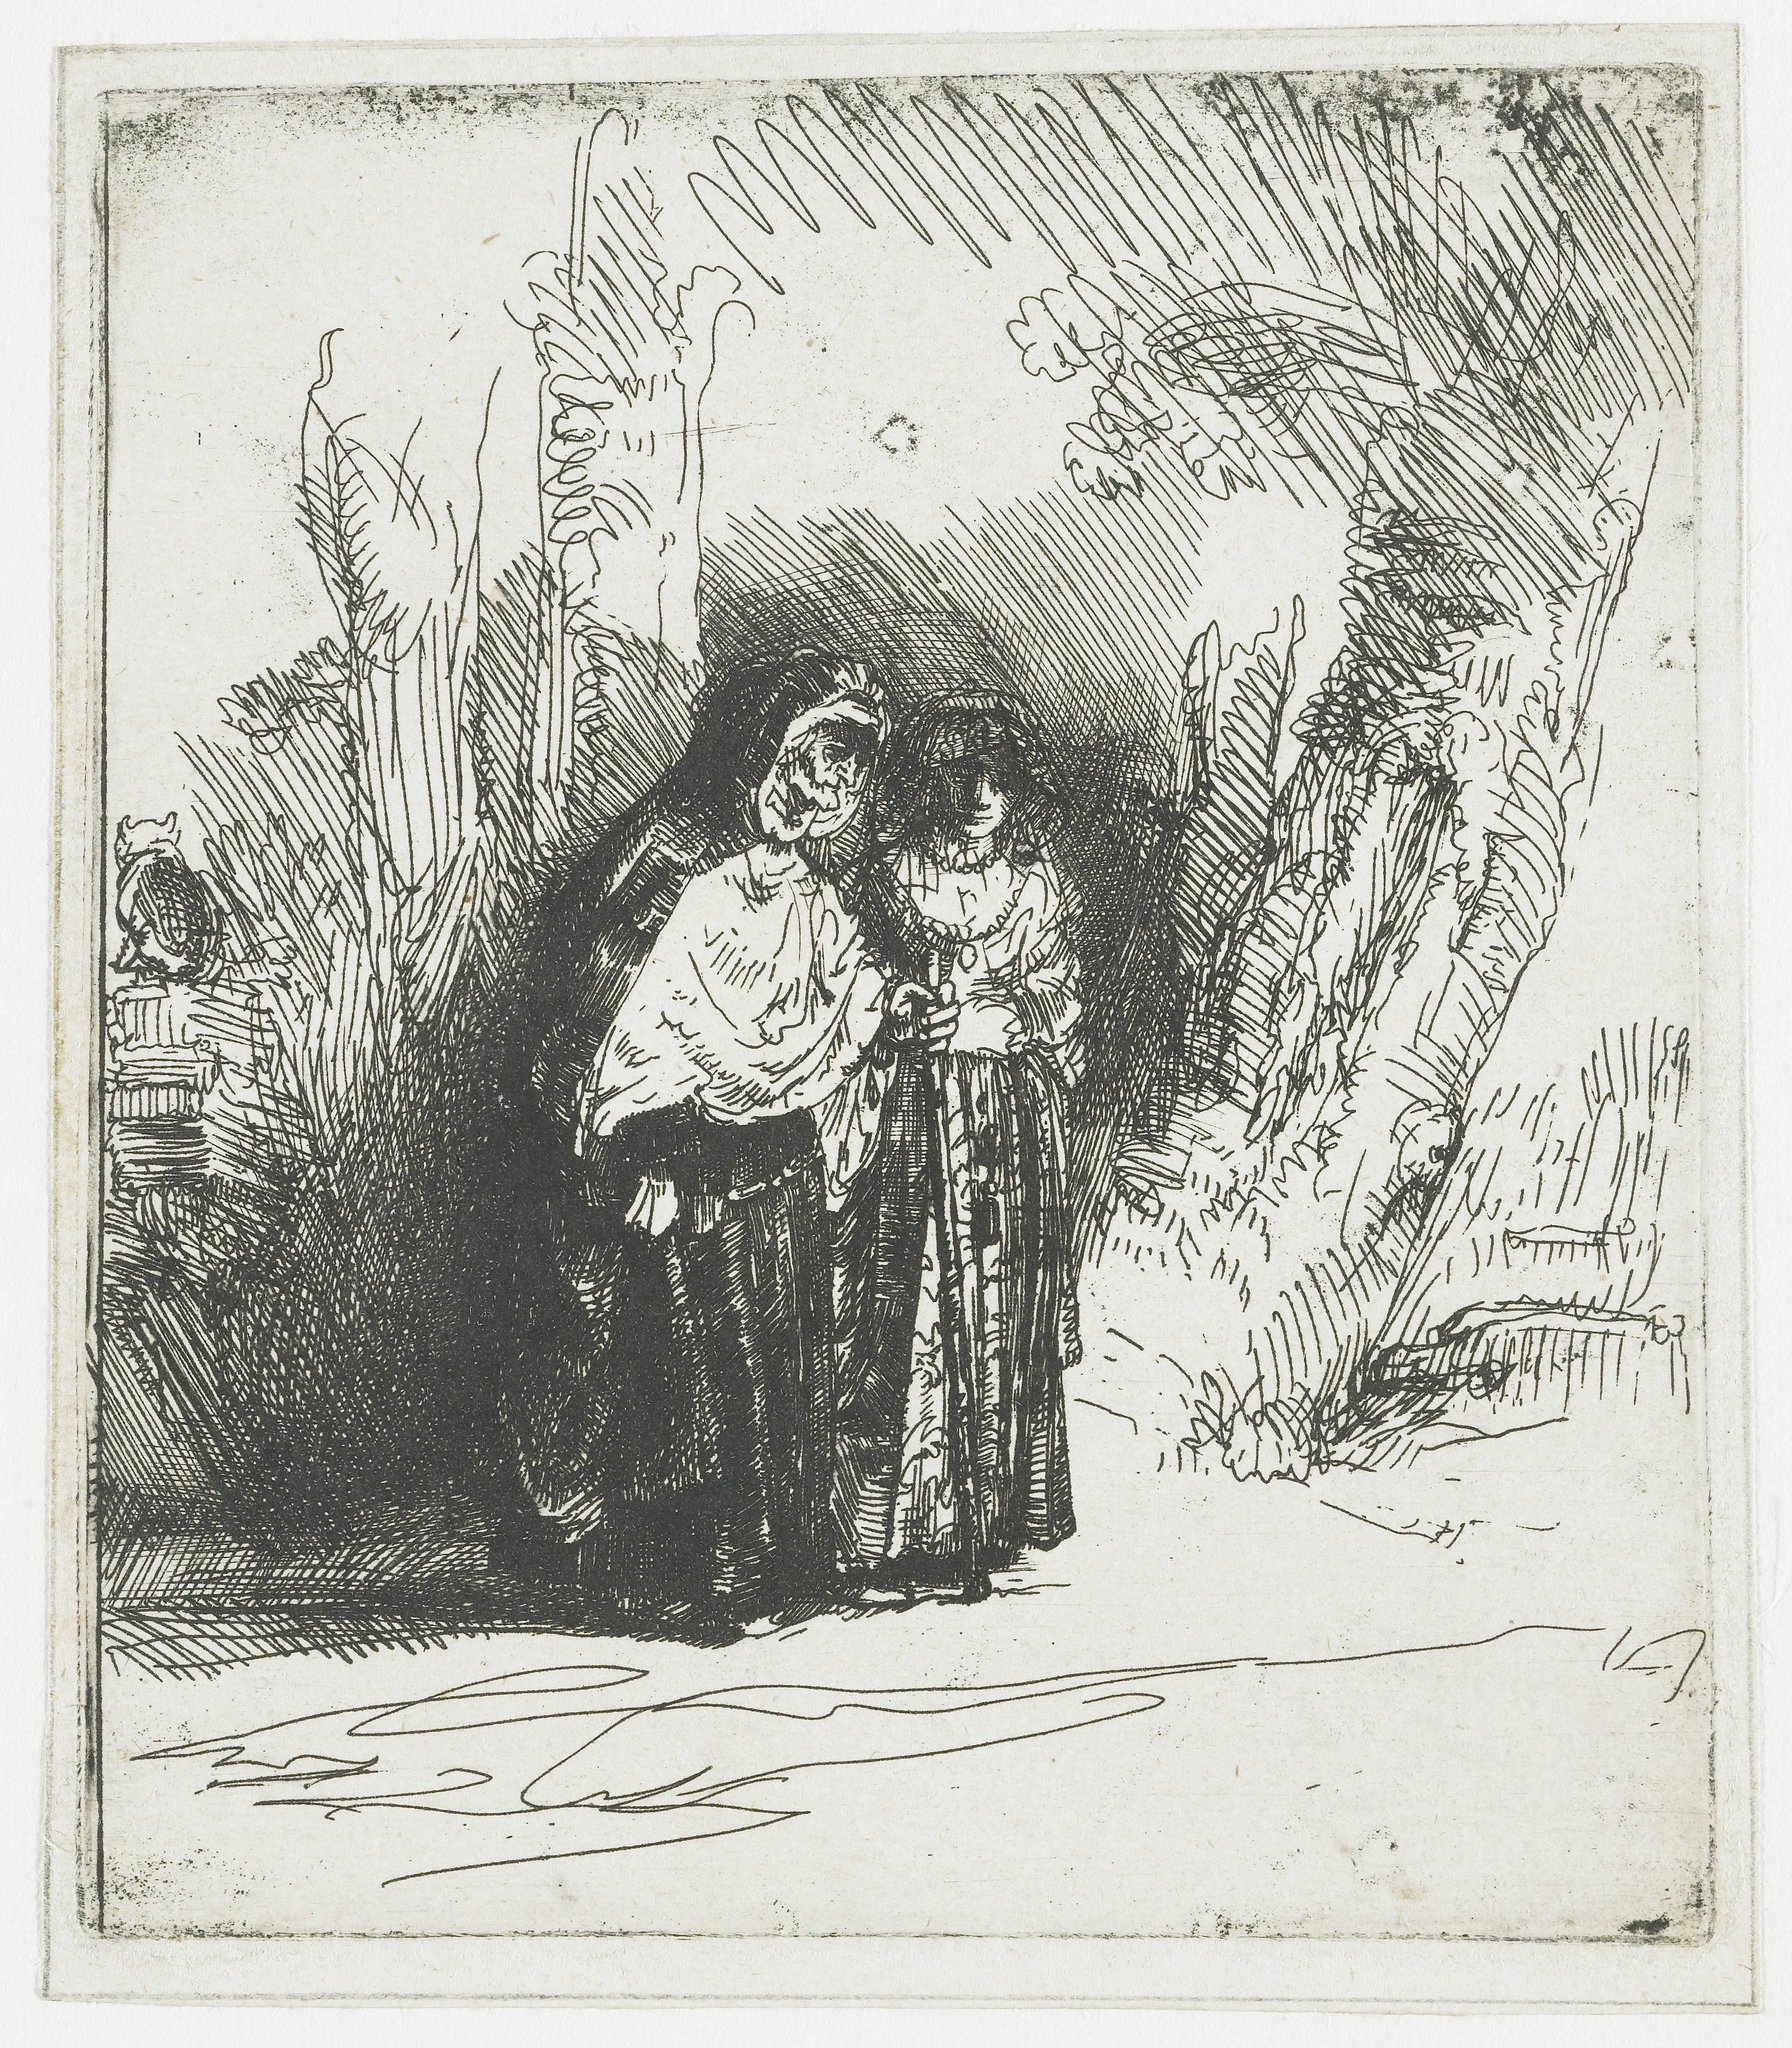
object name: print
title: The Spanish Gypsy Preciosa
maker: rembrandt van rijn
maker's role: draughtsman, painter, print maker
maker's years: 1606-1669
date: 1642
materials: paper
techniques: etching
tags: wandering communities: romani or roma, preciosa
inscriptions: collector's mark: Lugt 240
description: Here the destitute Preciosa and Majombe, the gypsy woman who reared her, are having a private chat. By happy coincidence, Preciosa ultimately marries a nobleman and turns out to be highborn herself. In Rembrandt’s time, this old story was staged under the title Het Spaensch heydinnetje (The Spanish Gypsy Woman). The print was probably intended for the play’s title page, but was never used.